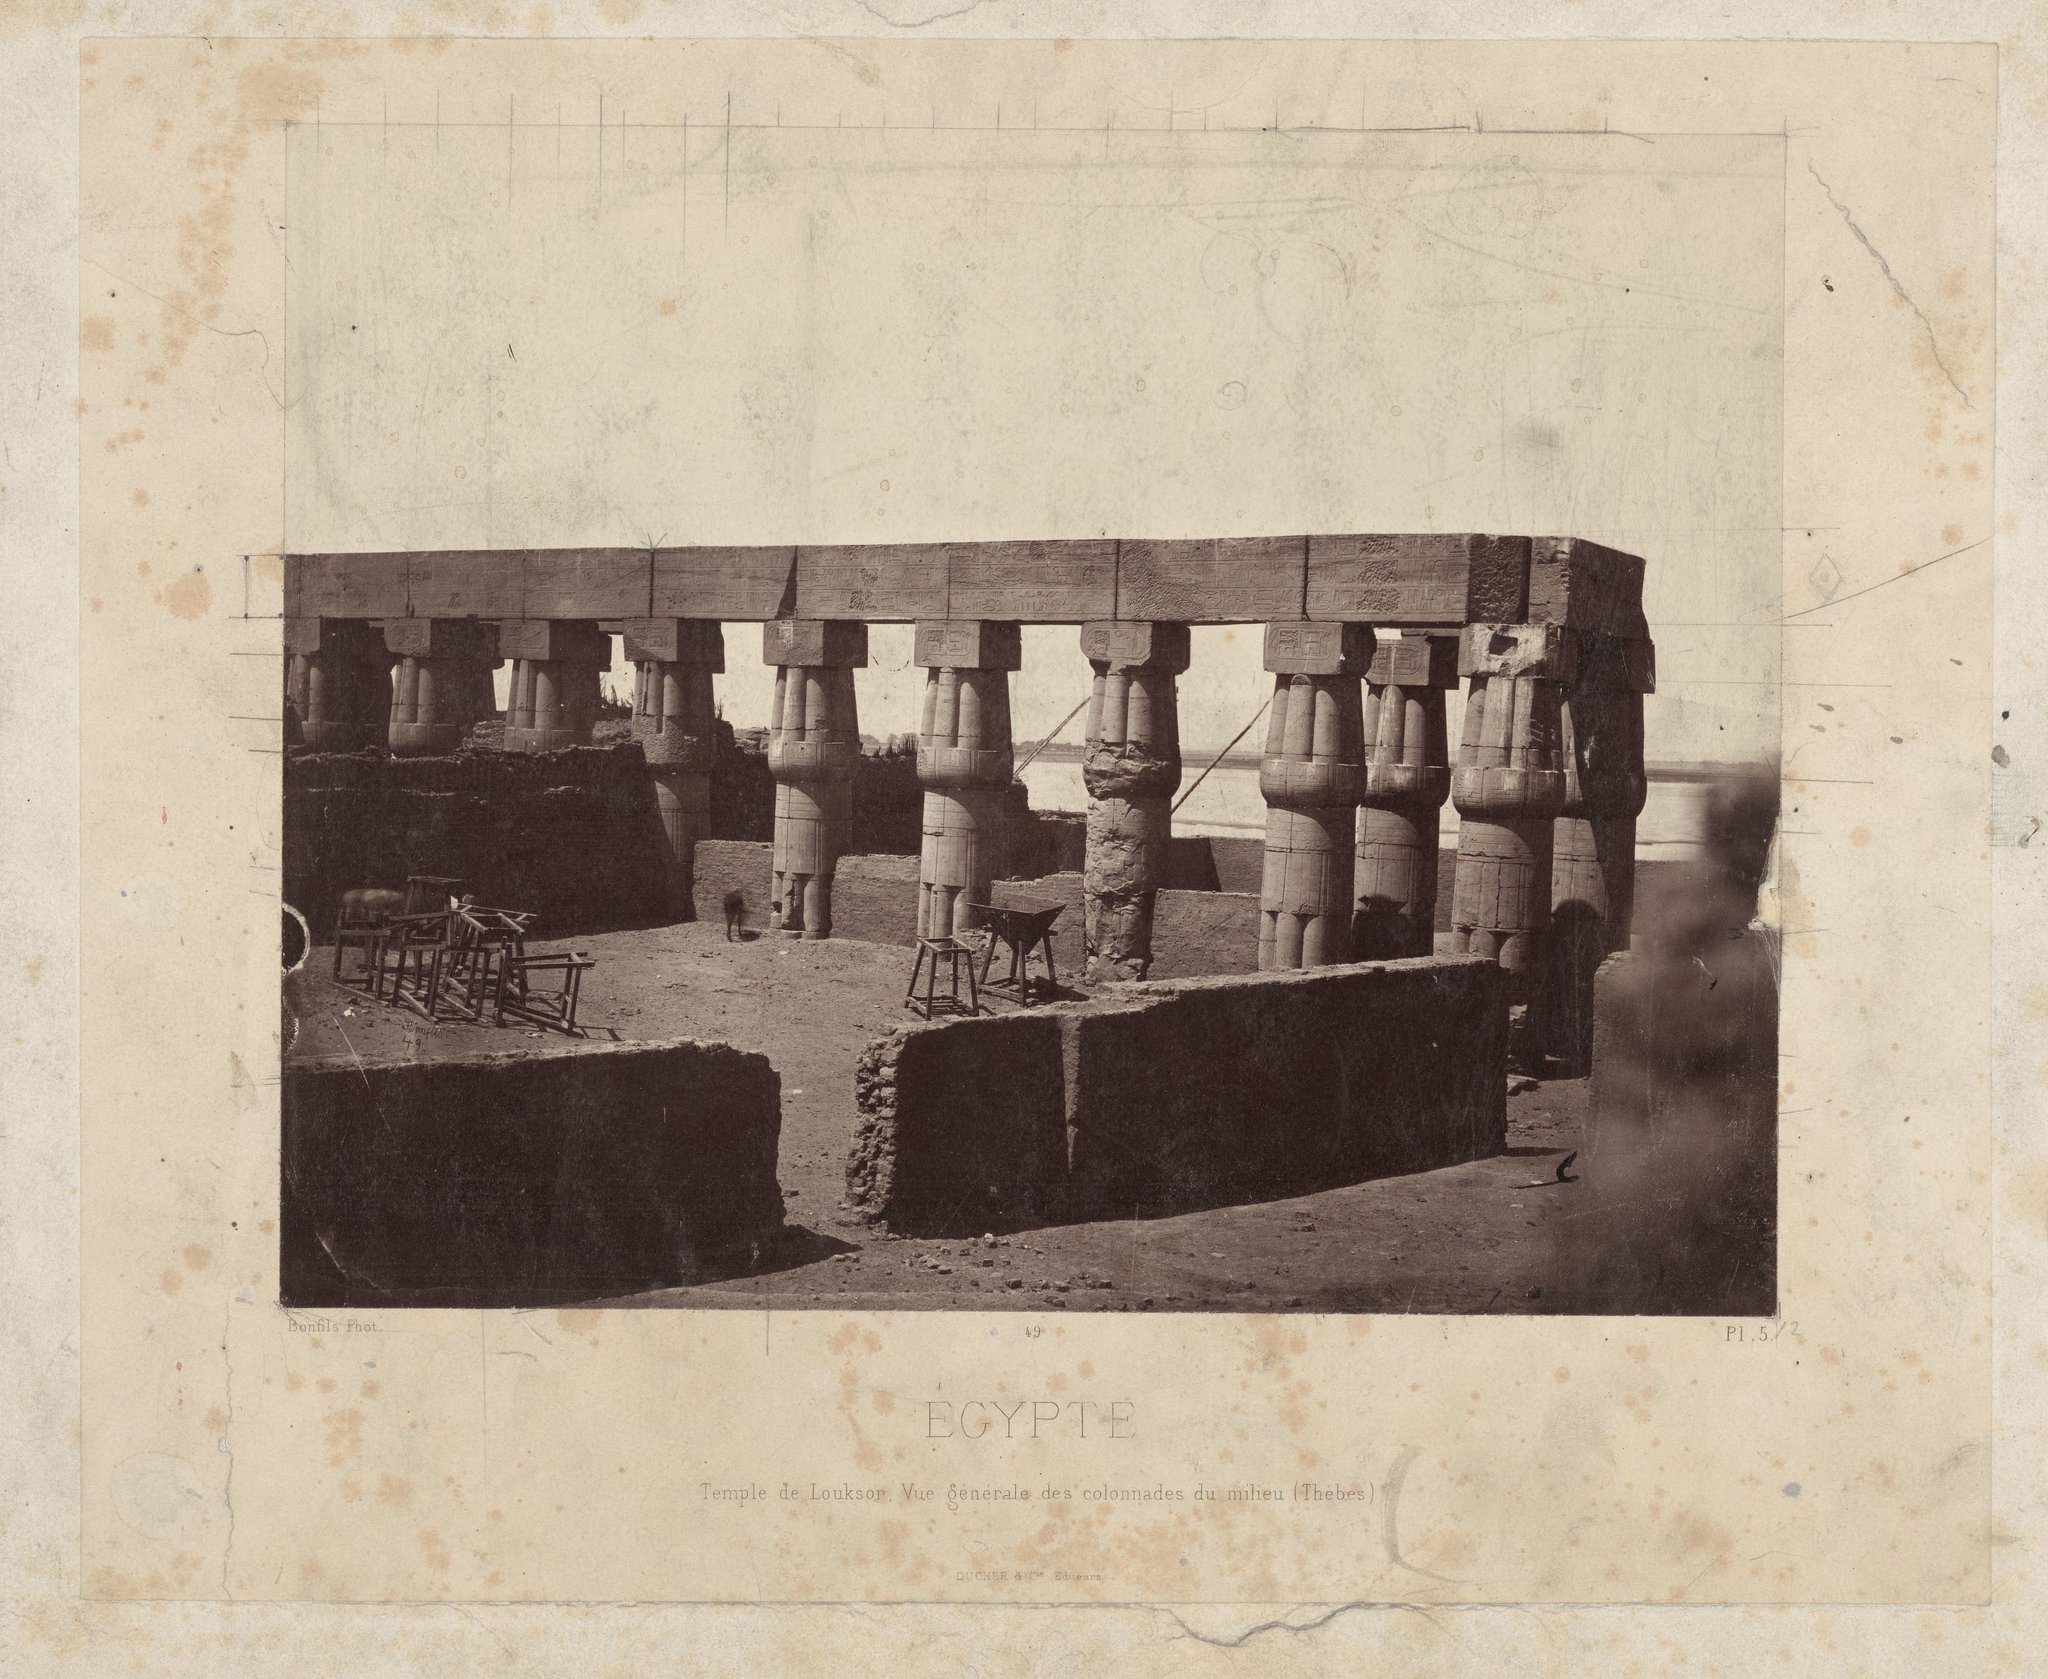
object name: photograph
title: Égypte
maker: félix bonfils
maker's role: fotograaf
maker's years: 1831-1885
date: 1867-1872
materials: textile, cardboard, ink, paper, pencil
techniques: albumen print, pen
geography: paris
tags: temple, shrine ~ egyptian religion, landscape with ruins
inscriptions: number: ‘49’, number: ‘Pl. 5.’